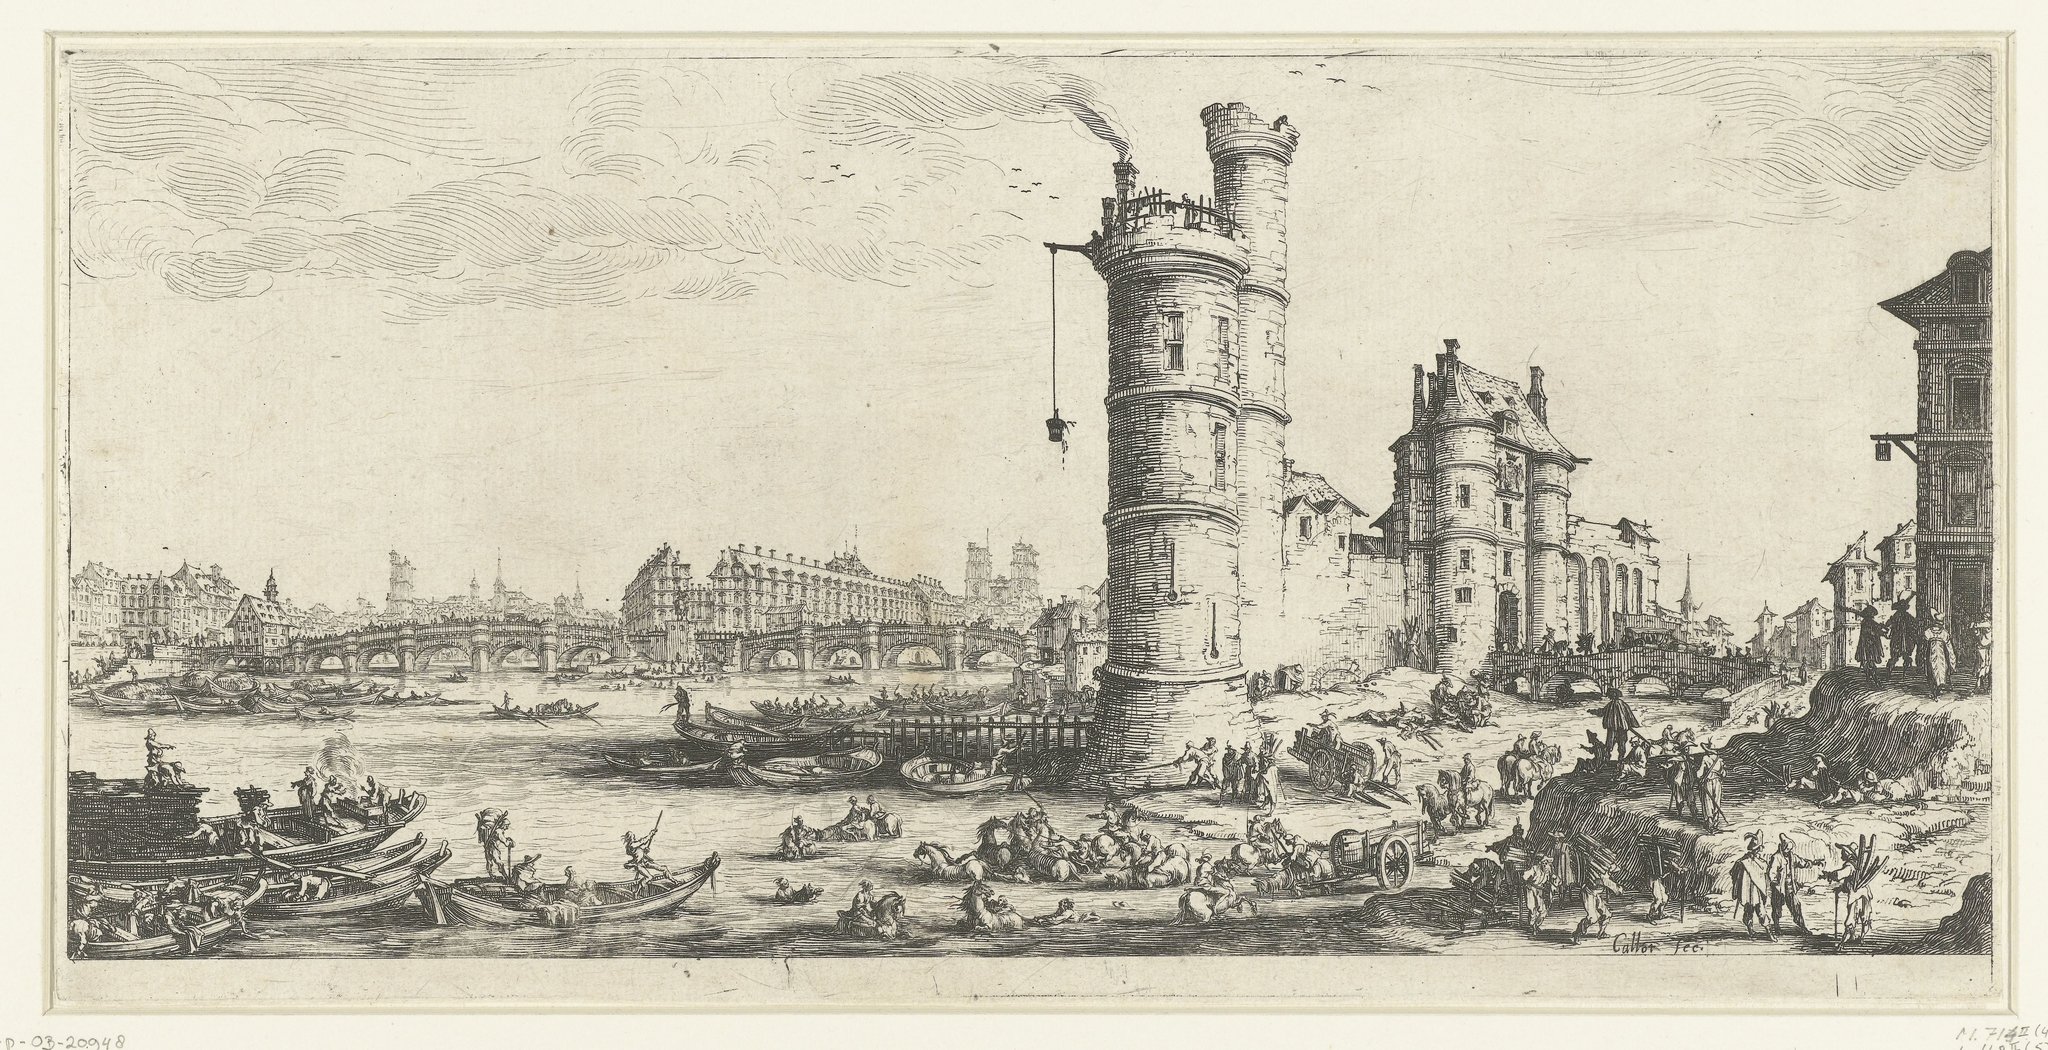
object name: print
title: Gezicht op de Seine met de Pont Neuf te Parijs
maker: jacques callot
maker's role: draughtsman, print maker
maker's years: 1592-1635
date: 1630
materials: paper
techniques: etching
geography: nancy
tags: tower, clock tower ~ monumental adornment, city-view in general; 'veduta', river, ships (in general), horse, bridge in village across river, canal, etc., paris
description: Tussen de Pont Neuf op de achtergrond en de Tour de Nesle op de voorgrond liggen vele schepen met diverse ladingen in de Seine. Aan de voet van de toren ook vele paarden in het water. Onder de voorstelling een lege marge. Deze prent is de pendant van een gezicht op de Seine met het Louvre te Parijs.